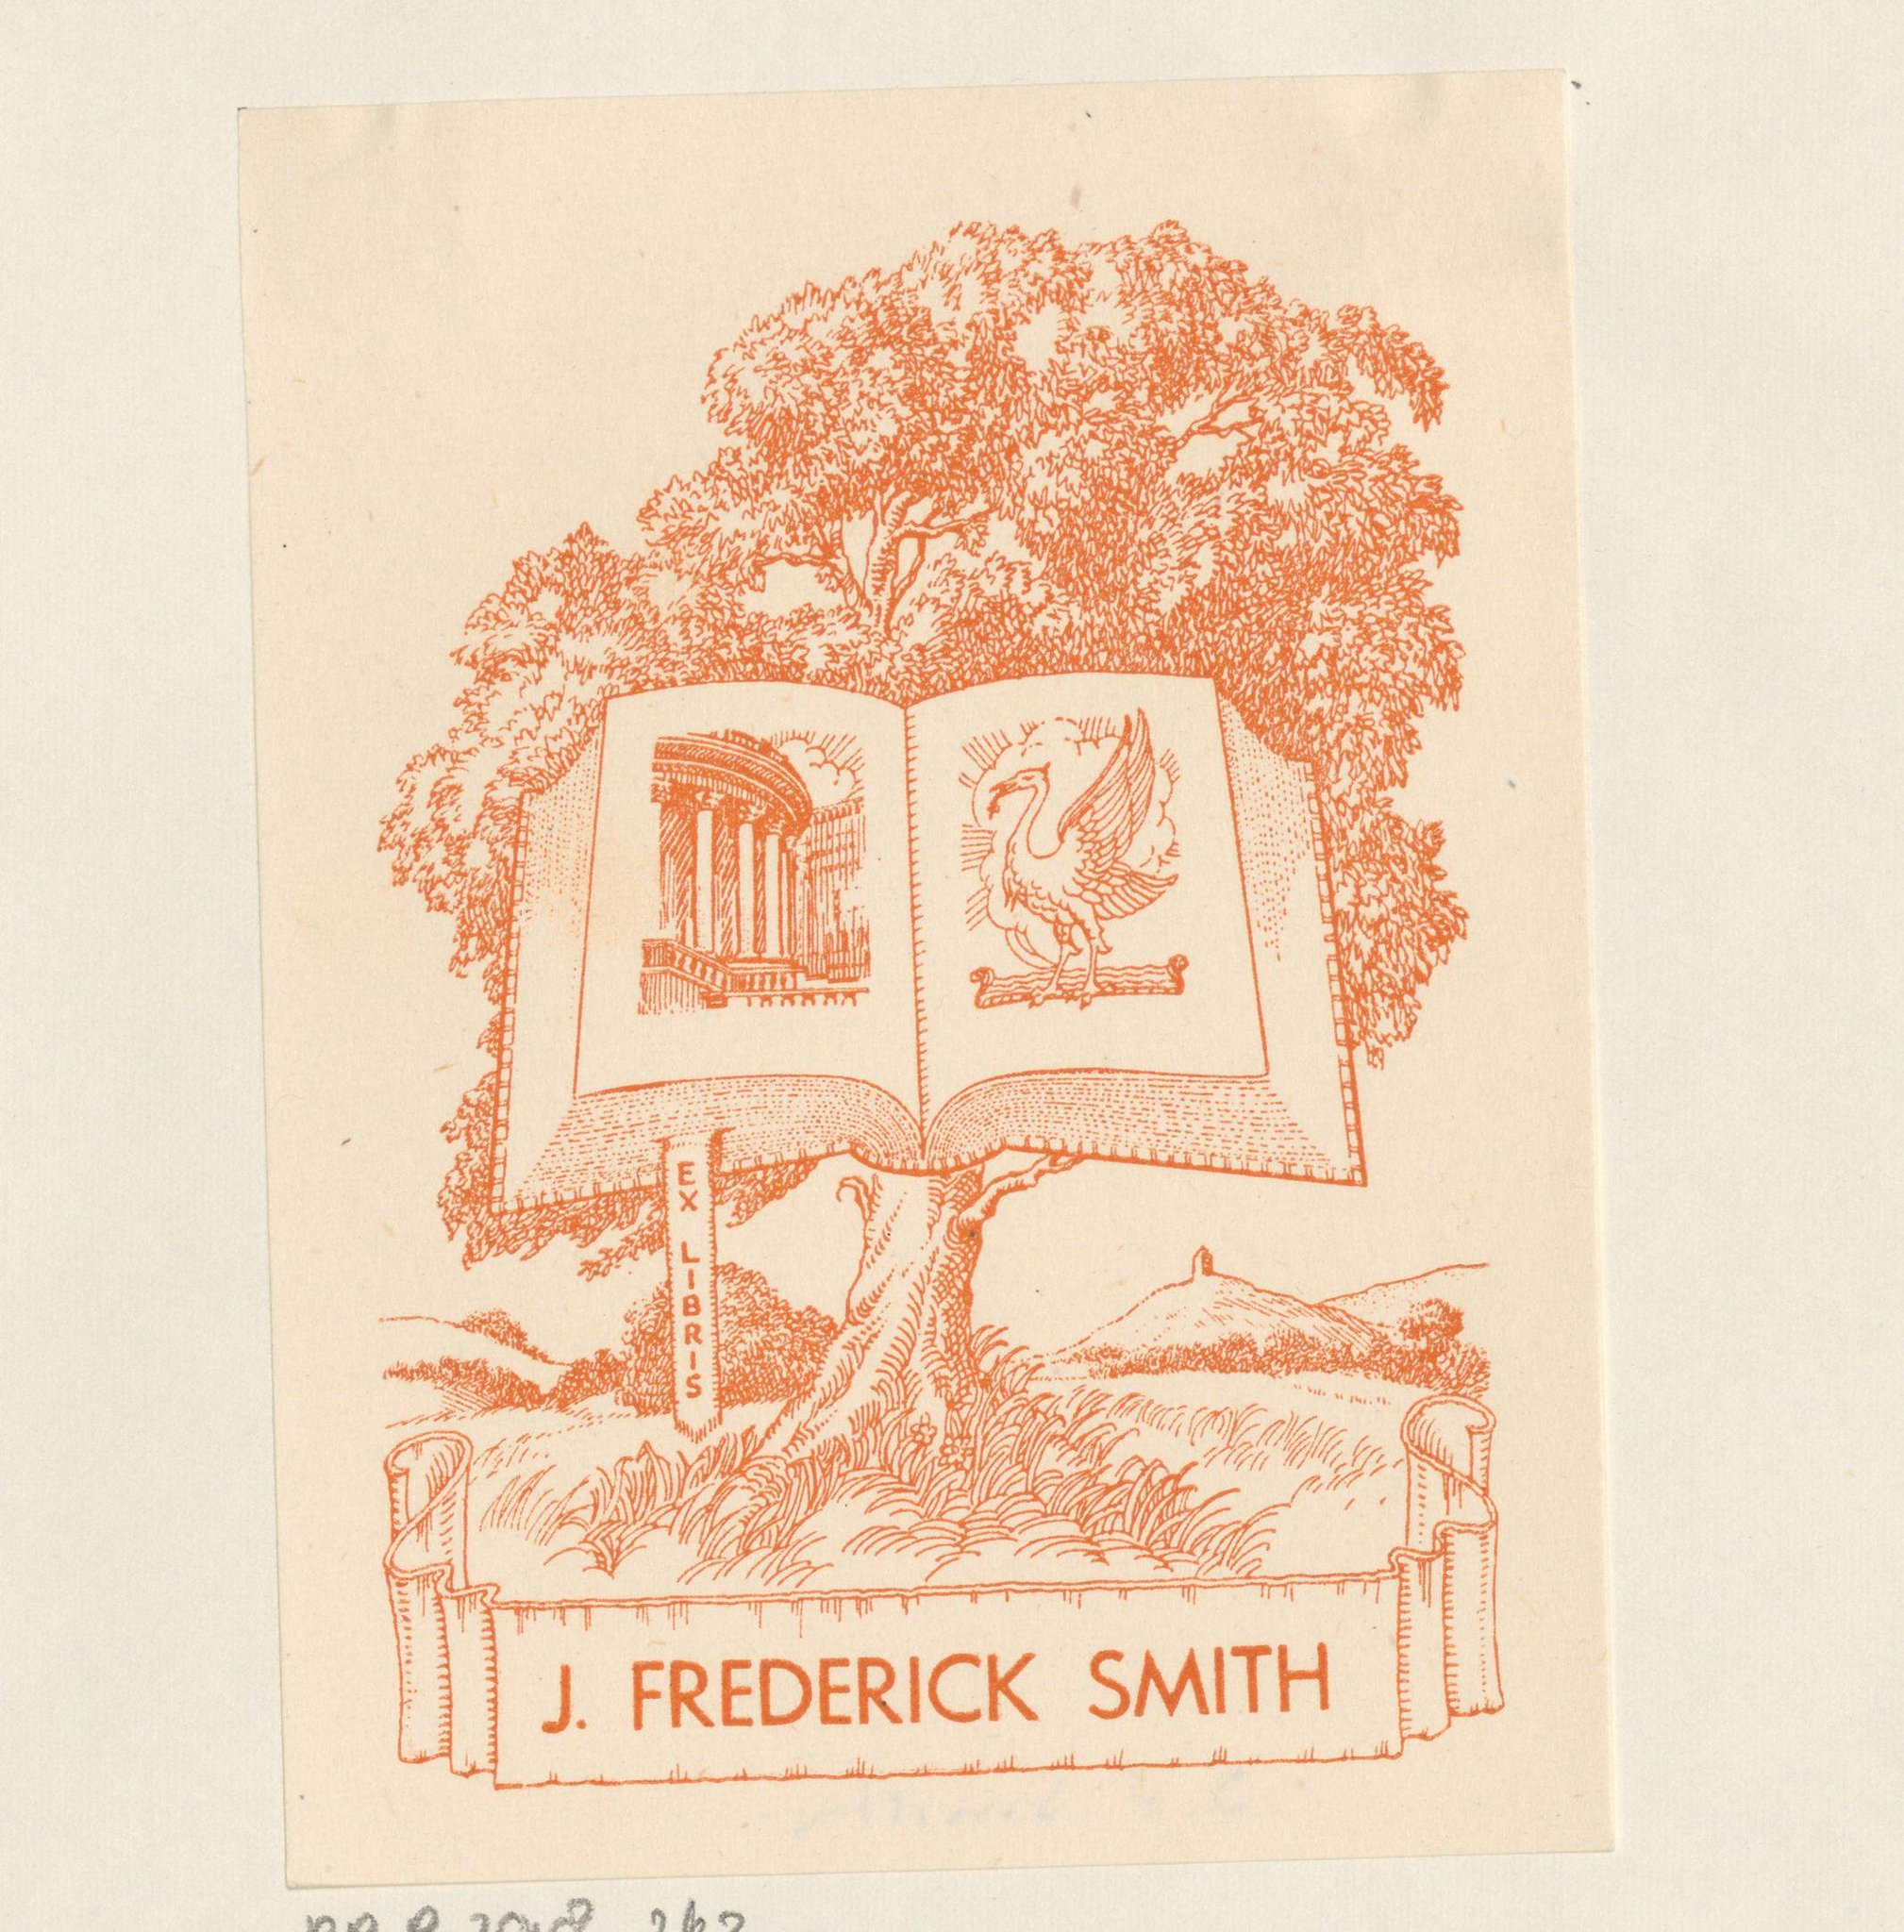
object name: bookplate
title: Ex libris van J. Frederick Smith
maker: Anonymous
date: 1870-1949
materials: paper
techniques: printing block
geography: england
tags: j. frederick smith, trees, landscapes, birds, book